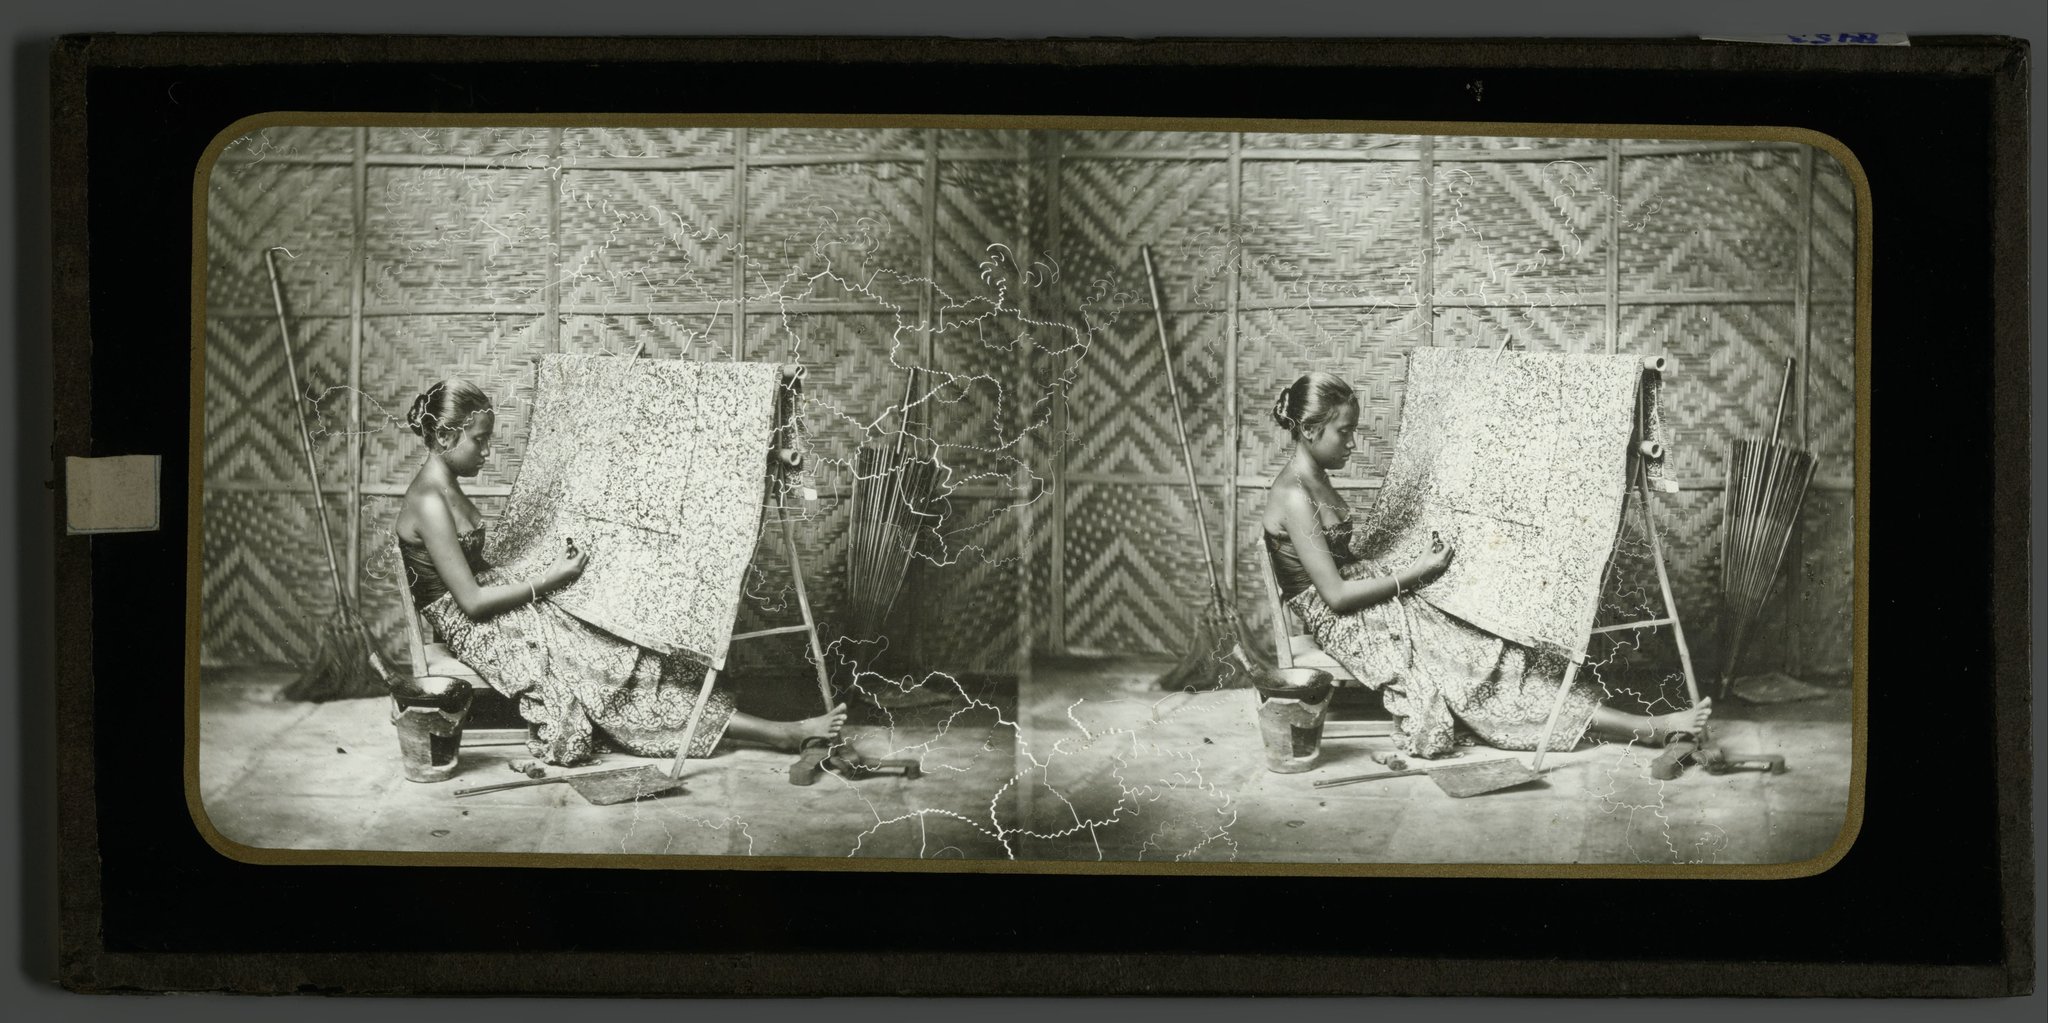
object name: photograph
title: Batikker aan het werk, mogelijk in Batavia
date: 1857-1864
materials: glass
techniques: slide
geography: batavia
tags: dyeing of cloth with pattern; batik-work, batavia